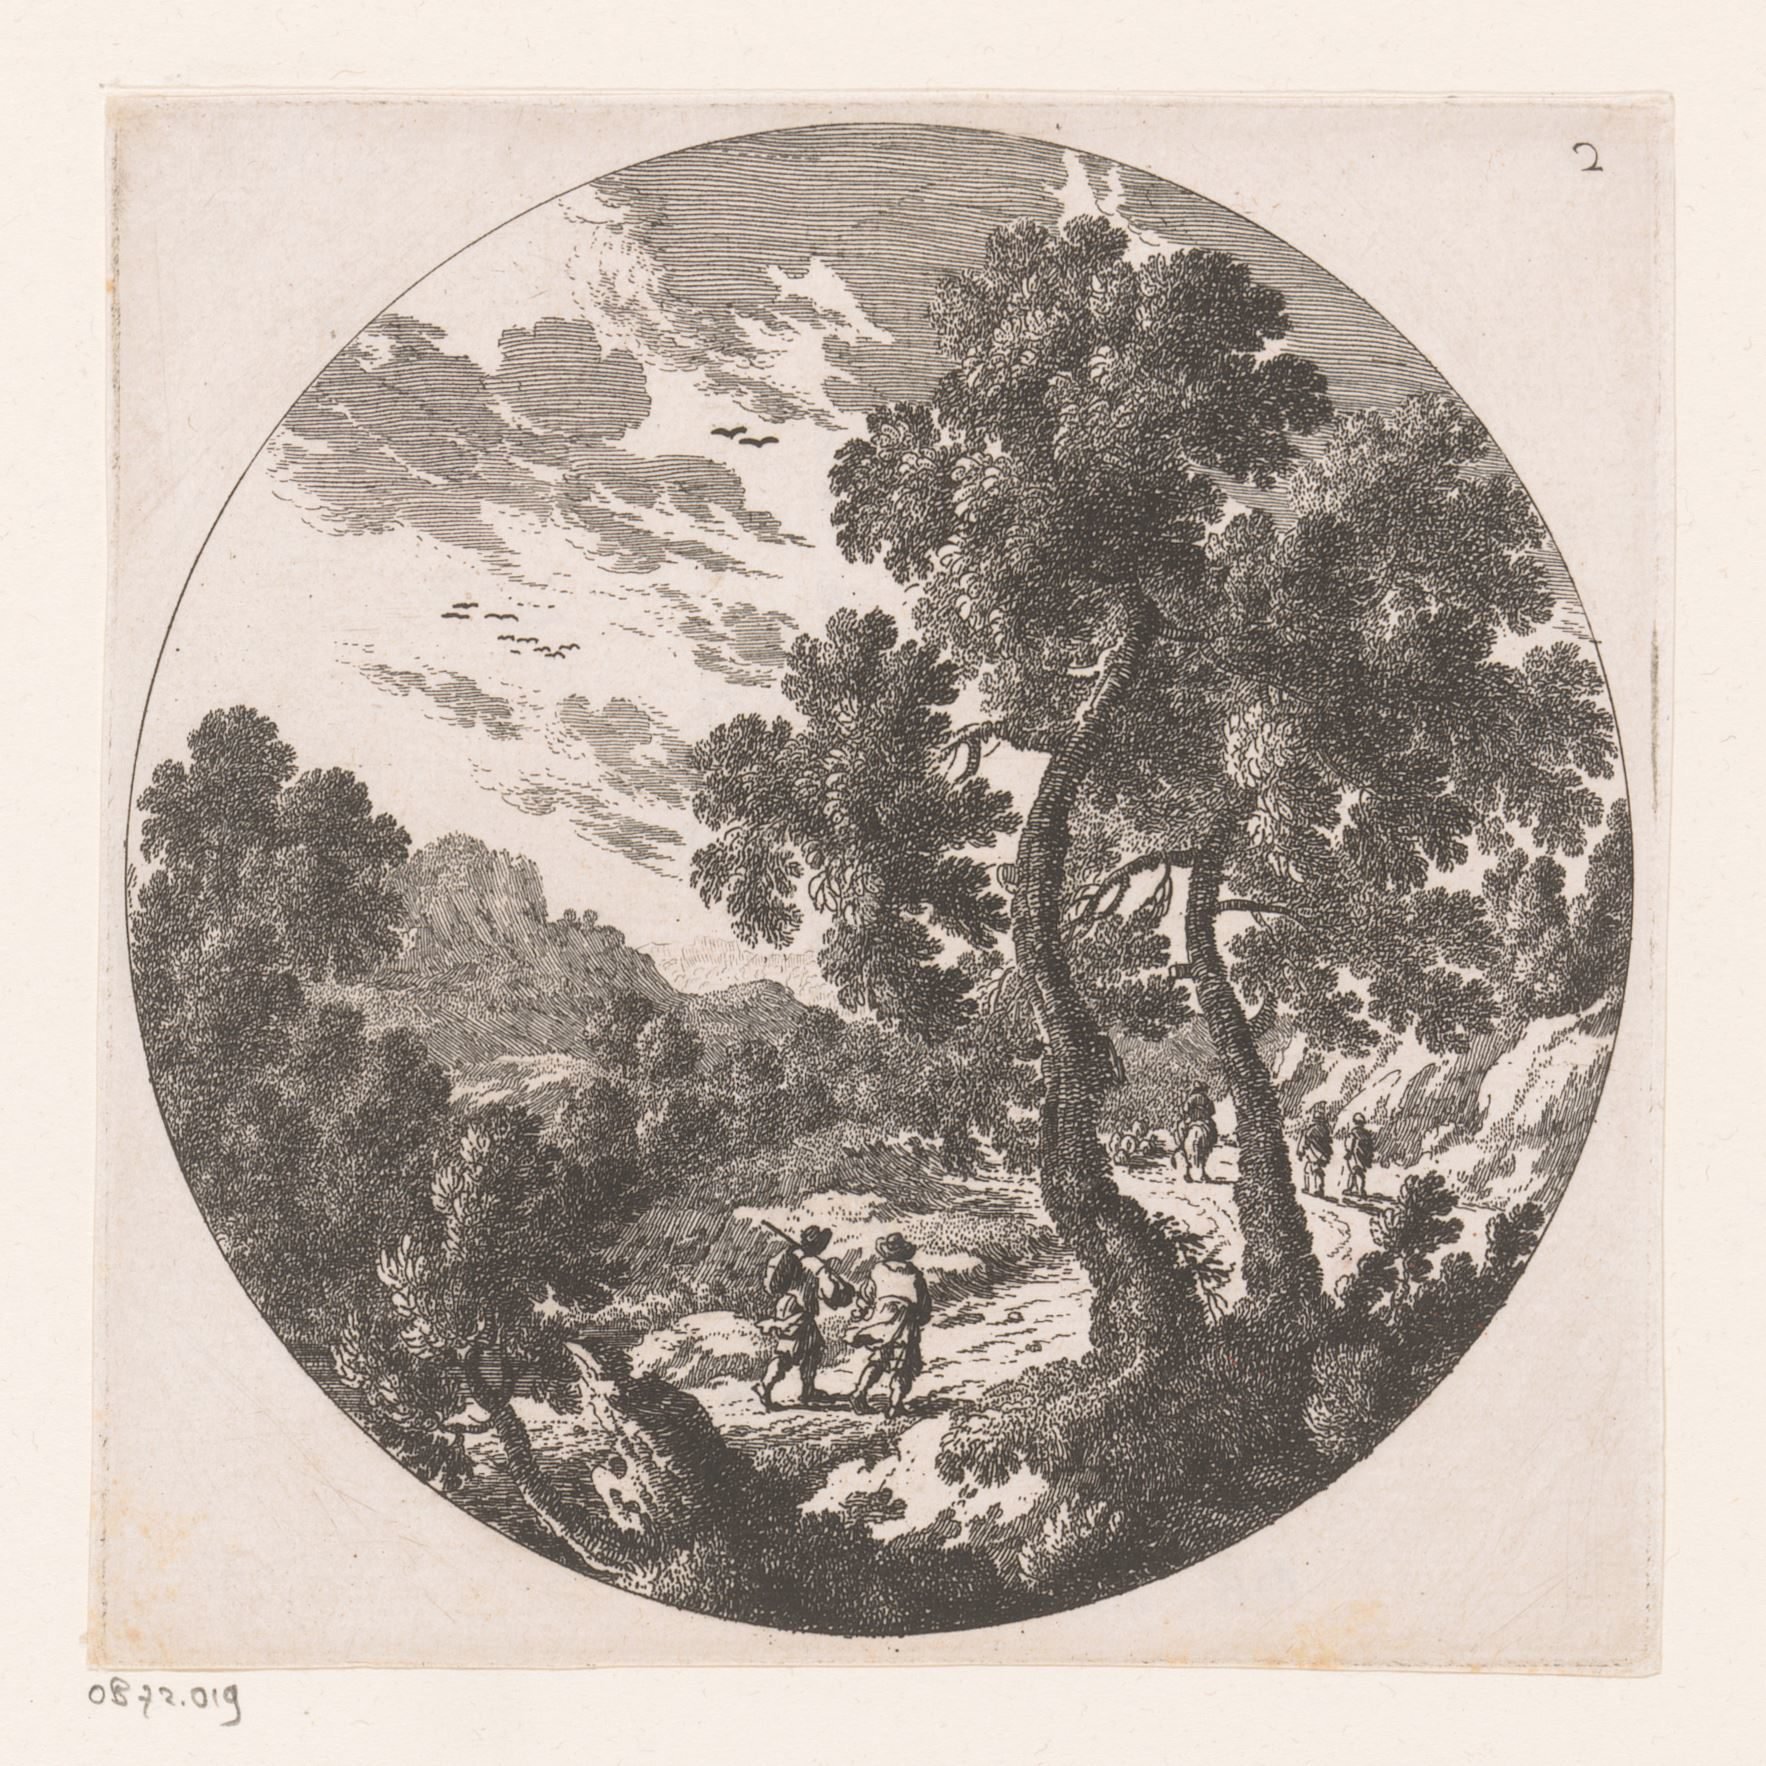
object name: print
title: Berglandschap met wandelaars op een weg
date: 1613-1695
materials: paper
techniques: etching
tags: trees, mountains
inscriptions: collector's mark: Lugt 240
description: Prenten met het signatuur 'Perelle' kunnen zowel door vader Gabriel als door zonen Nicolas en Adam gemaakt zijn.